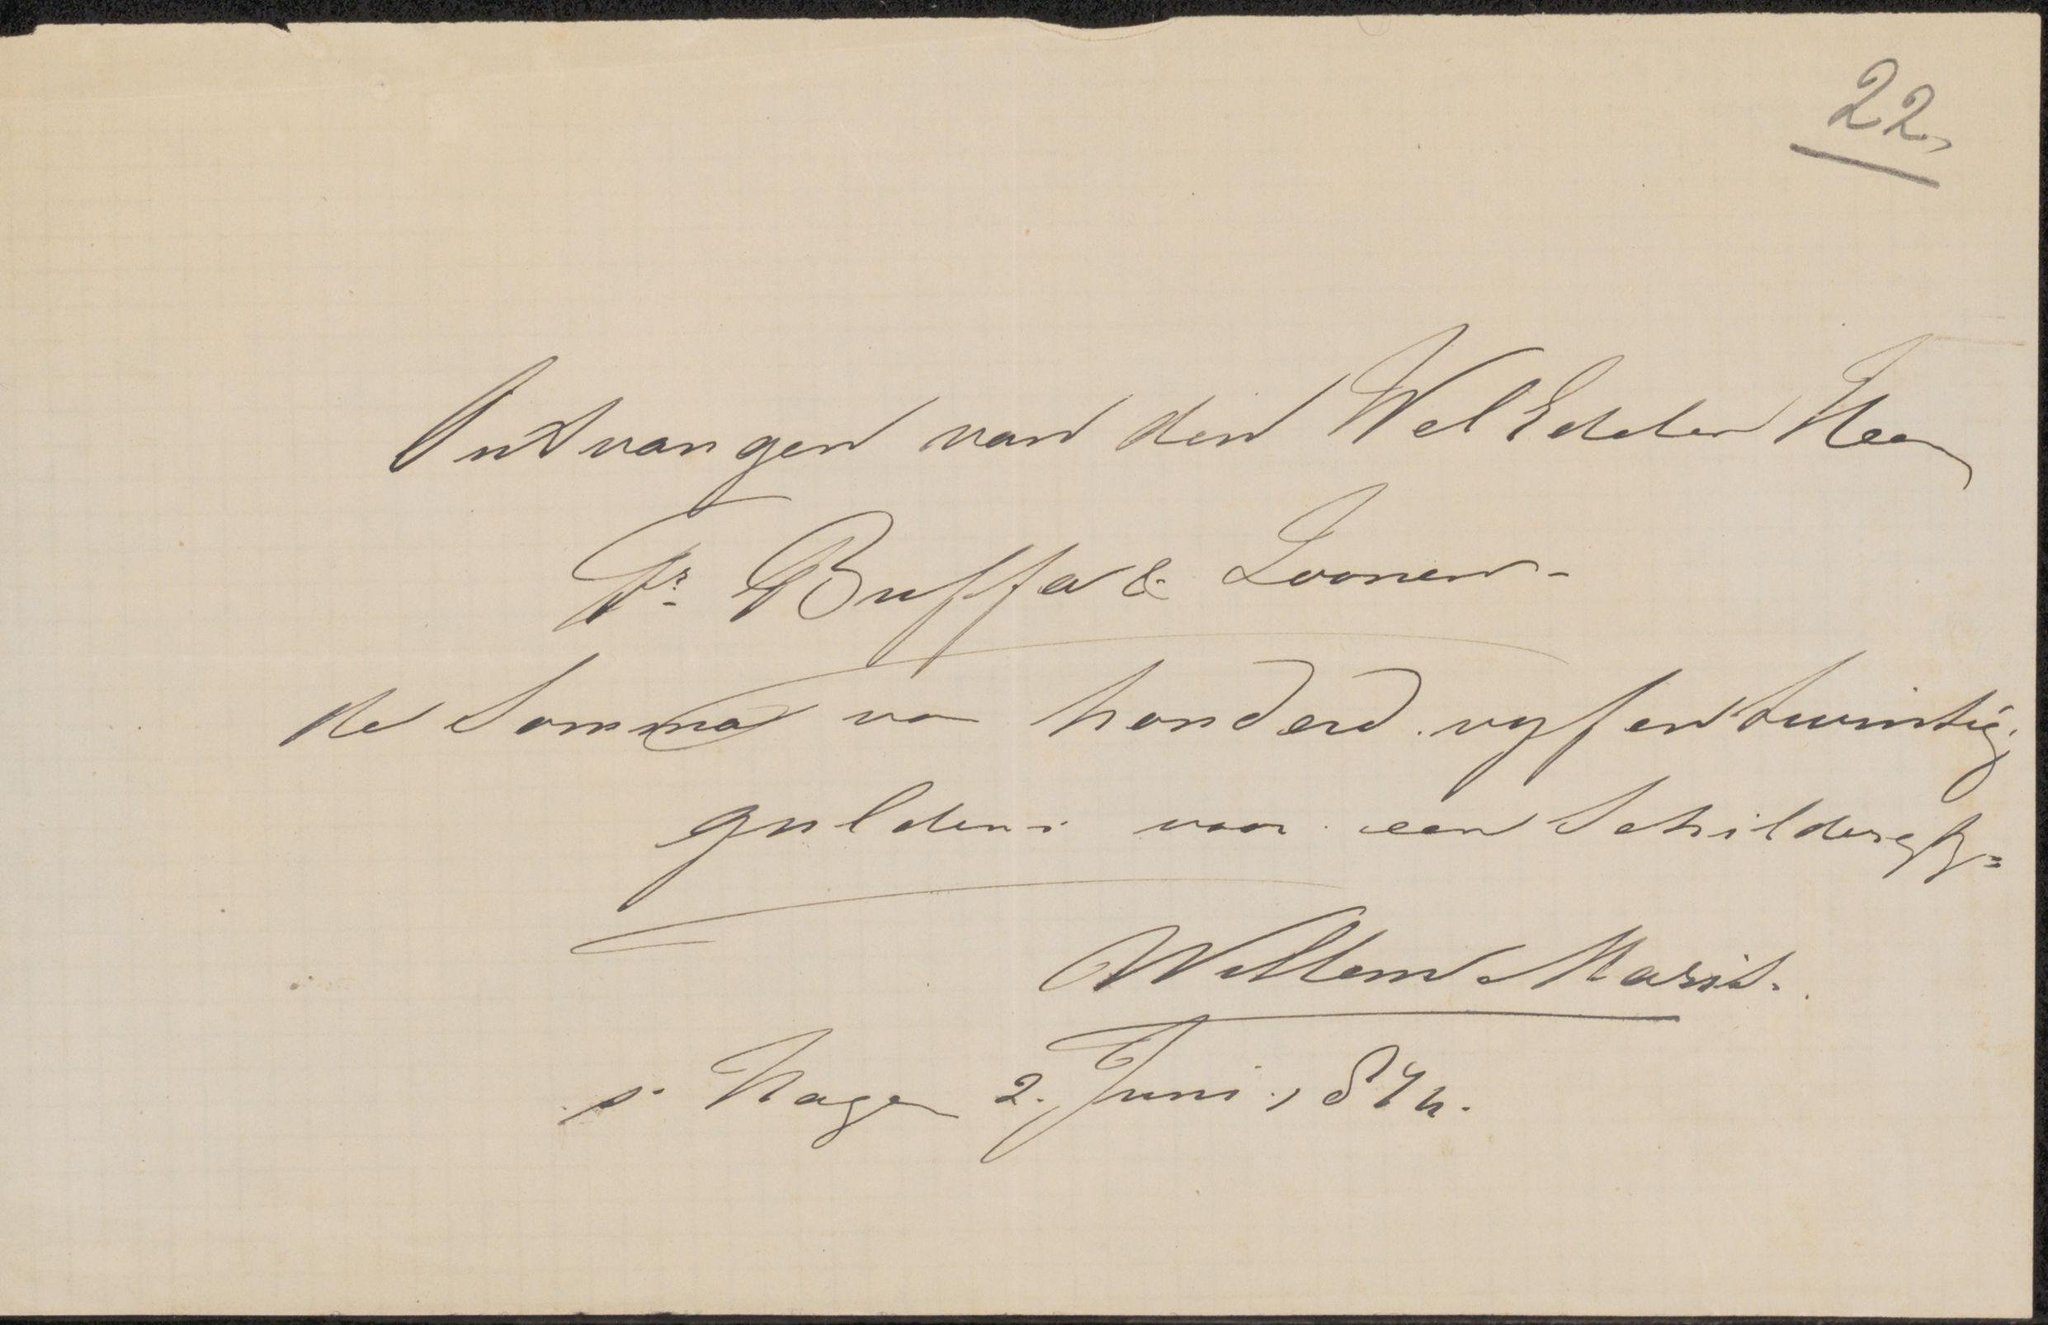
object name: ontvangstbewijs, kwitantie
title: Kwitantie voor Frans Buffa en Zonen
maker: willem maris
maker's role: draughtsman, painter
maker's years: 1844-1910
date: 1874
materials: ink, paper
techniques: pen, writing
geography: the hague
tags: publisher, art trade, art shop, painting (including book-illumination, miniature-painting), money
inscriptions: collector's mark: Lugt 2233, collector's mark: Lugt 2228